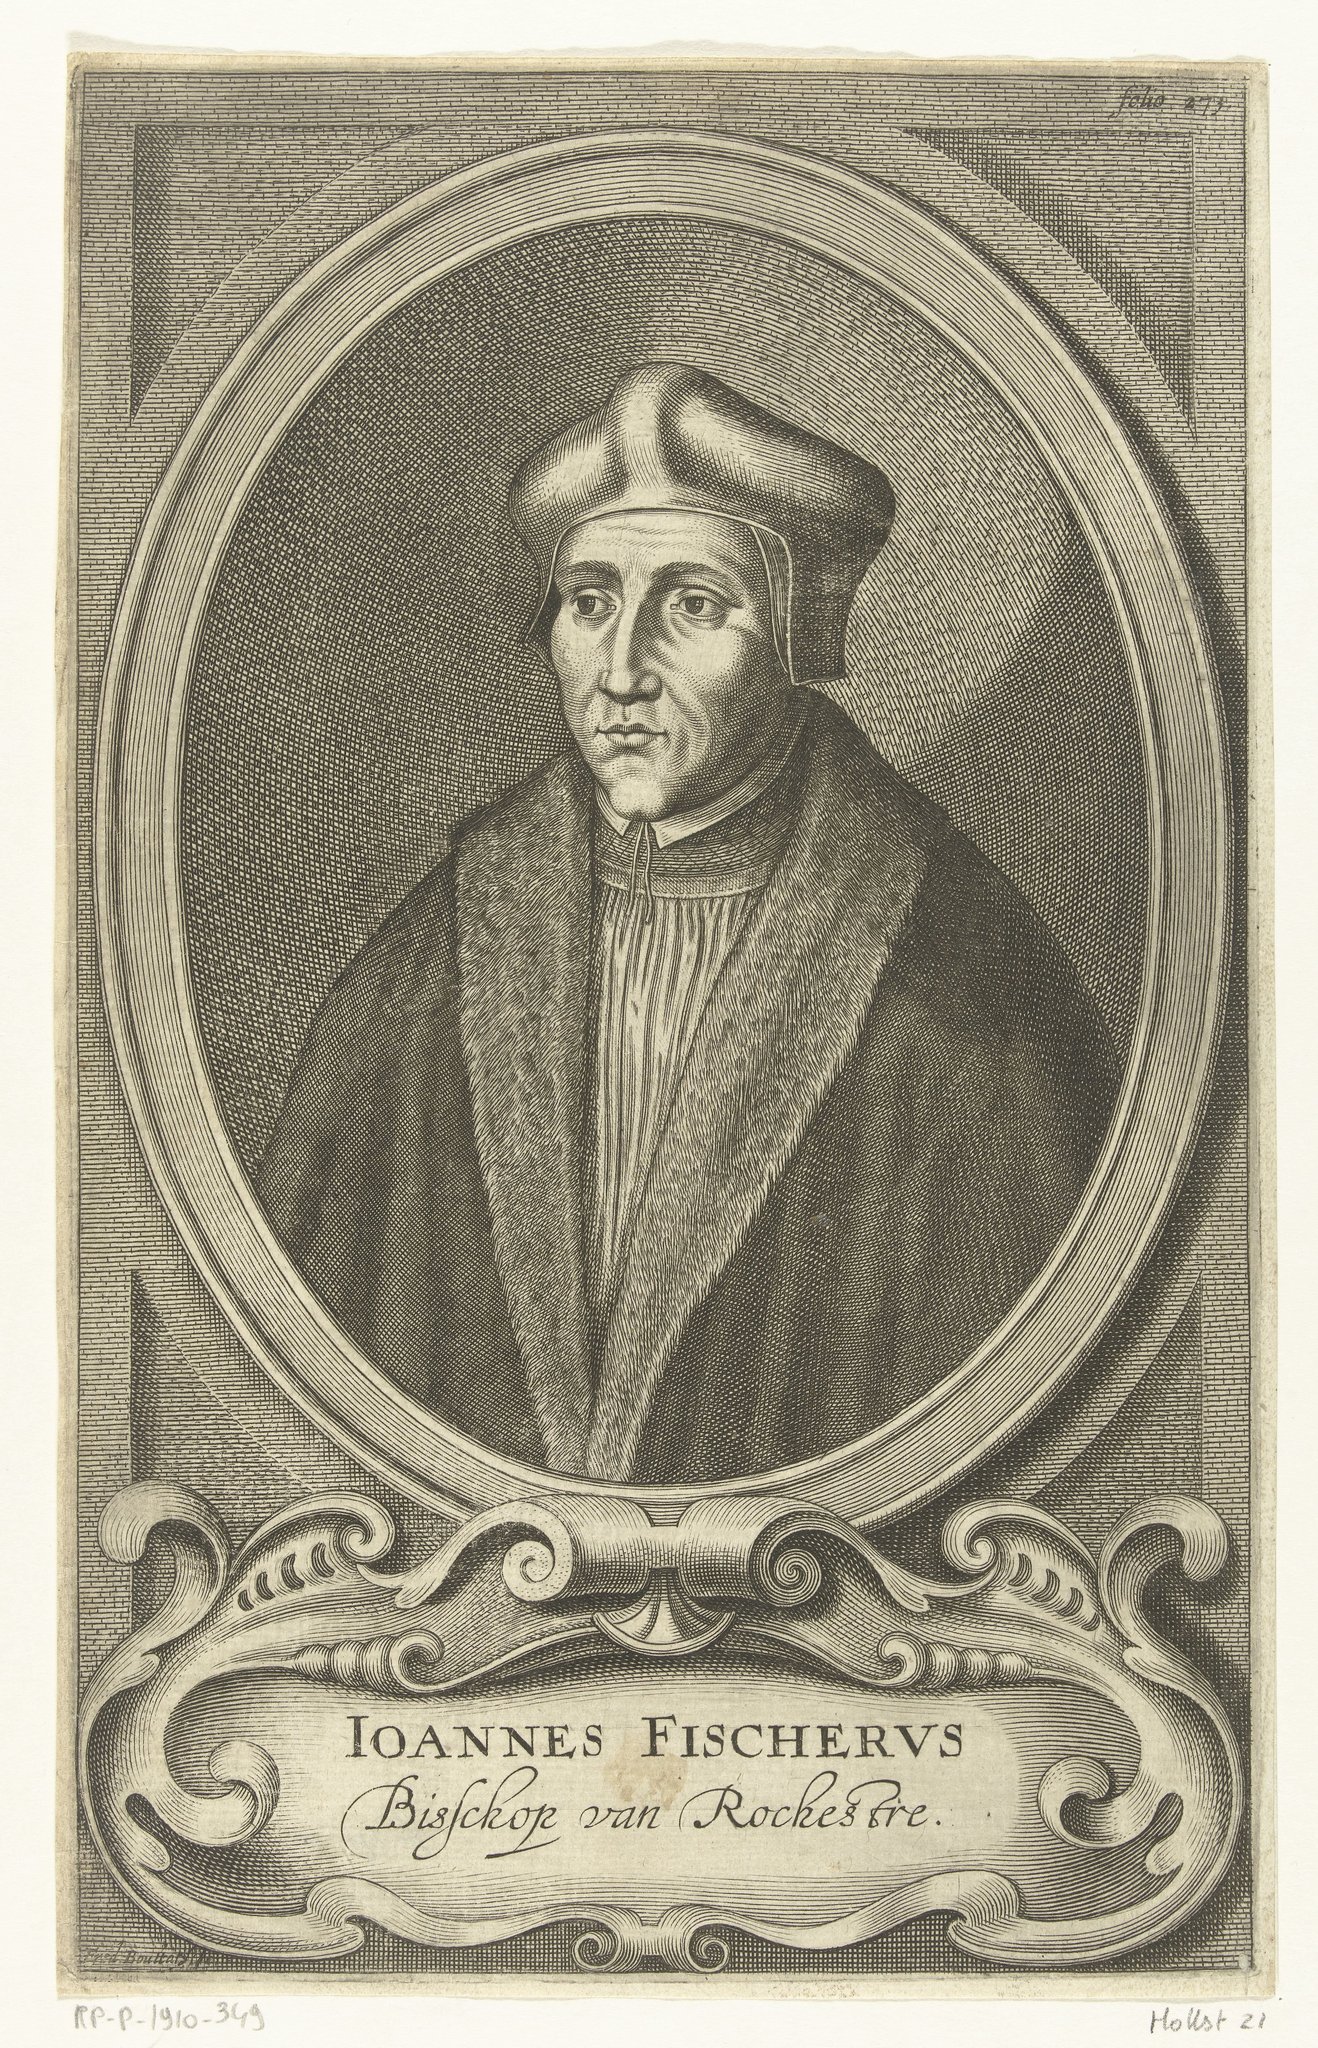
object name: print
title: Portret van John Fisher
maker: frederik bouttats (i)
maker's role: artist, painter, print maker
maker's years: 1590-1661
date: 1600-1676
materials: paper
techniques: engraving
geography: antwerp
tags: london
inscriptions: collector's mark: Lugt 2228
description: Portret in ovale lijst van John Fisher, bisschop van Rochester en katholiek martelaar. Onder het portret een cartouche met de naam van de geportretteerde.